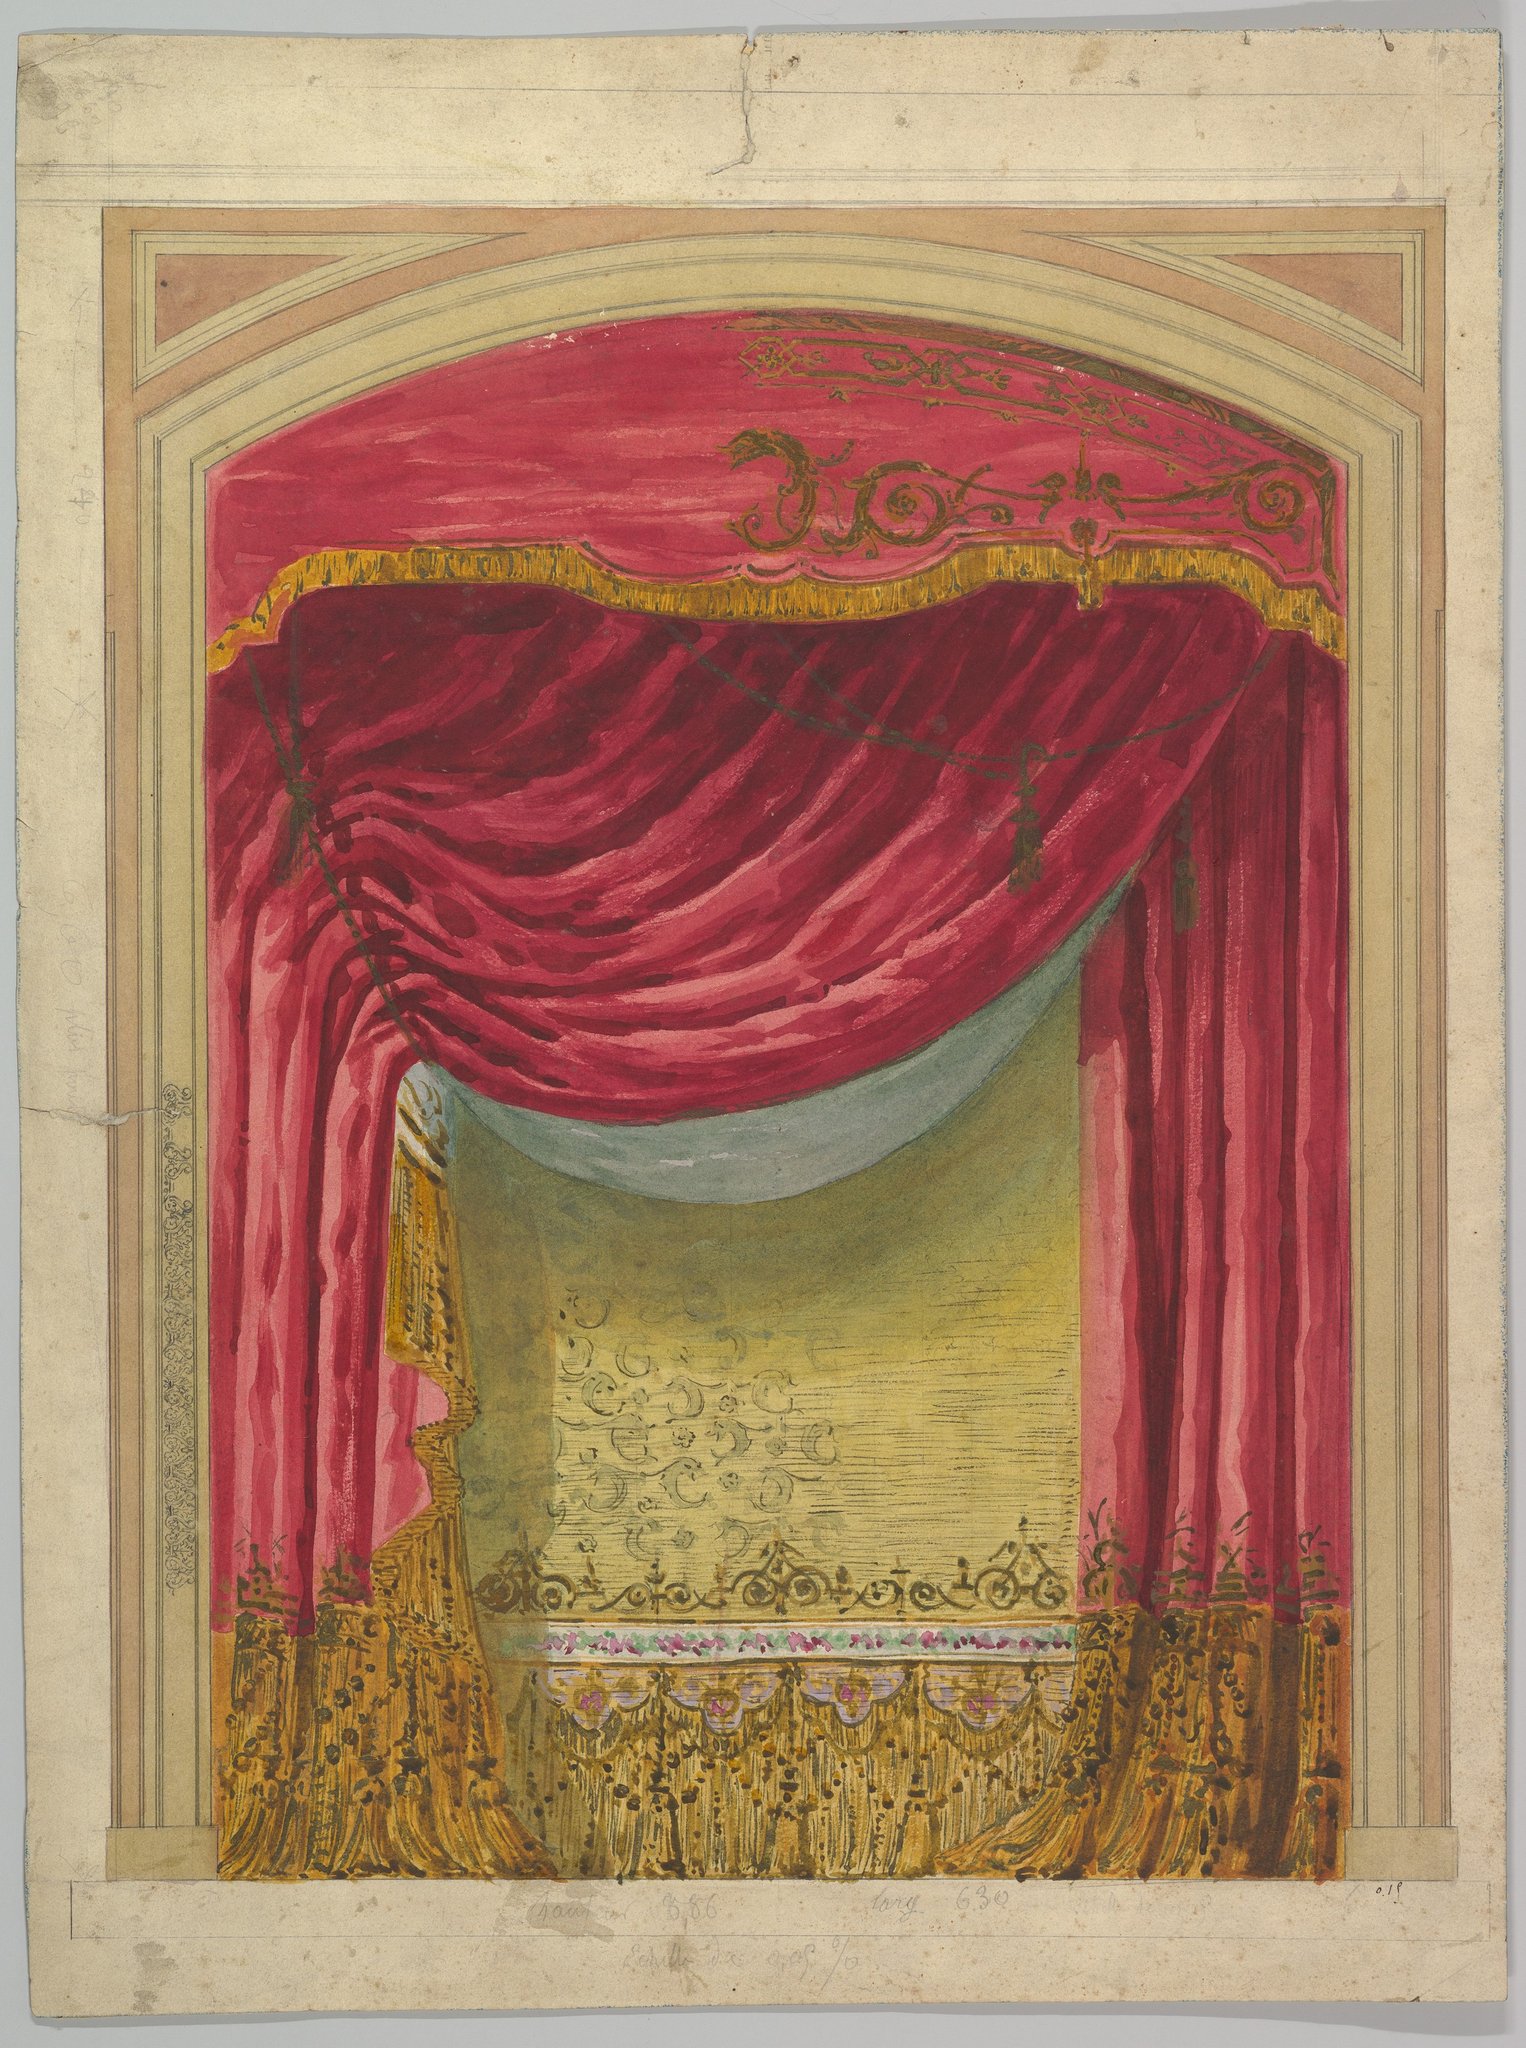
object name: drawing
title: Design for a Stage Set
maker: eugène cicéri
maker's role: artist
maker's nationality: french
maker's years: 1813-1890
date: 1830-1890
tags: theatre,curtains,stage design